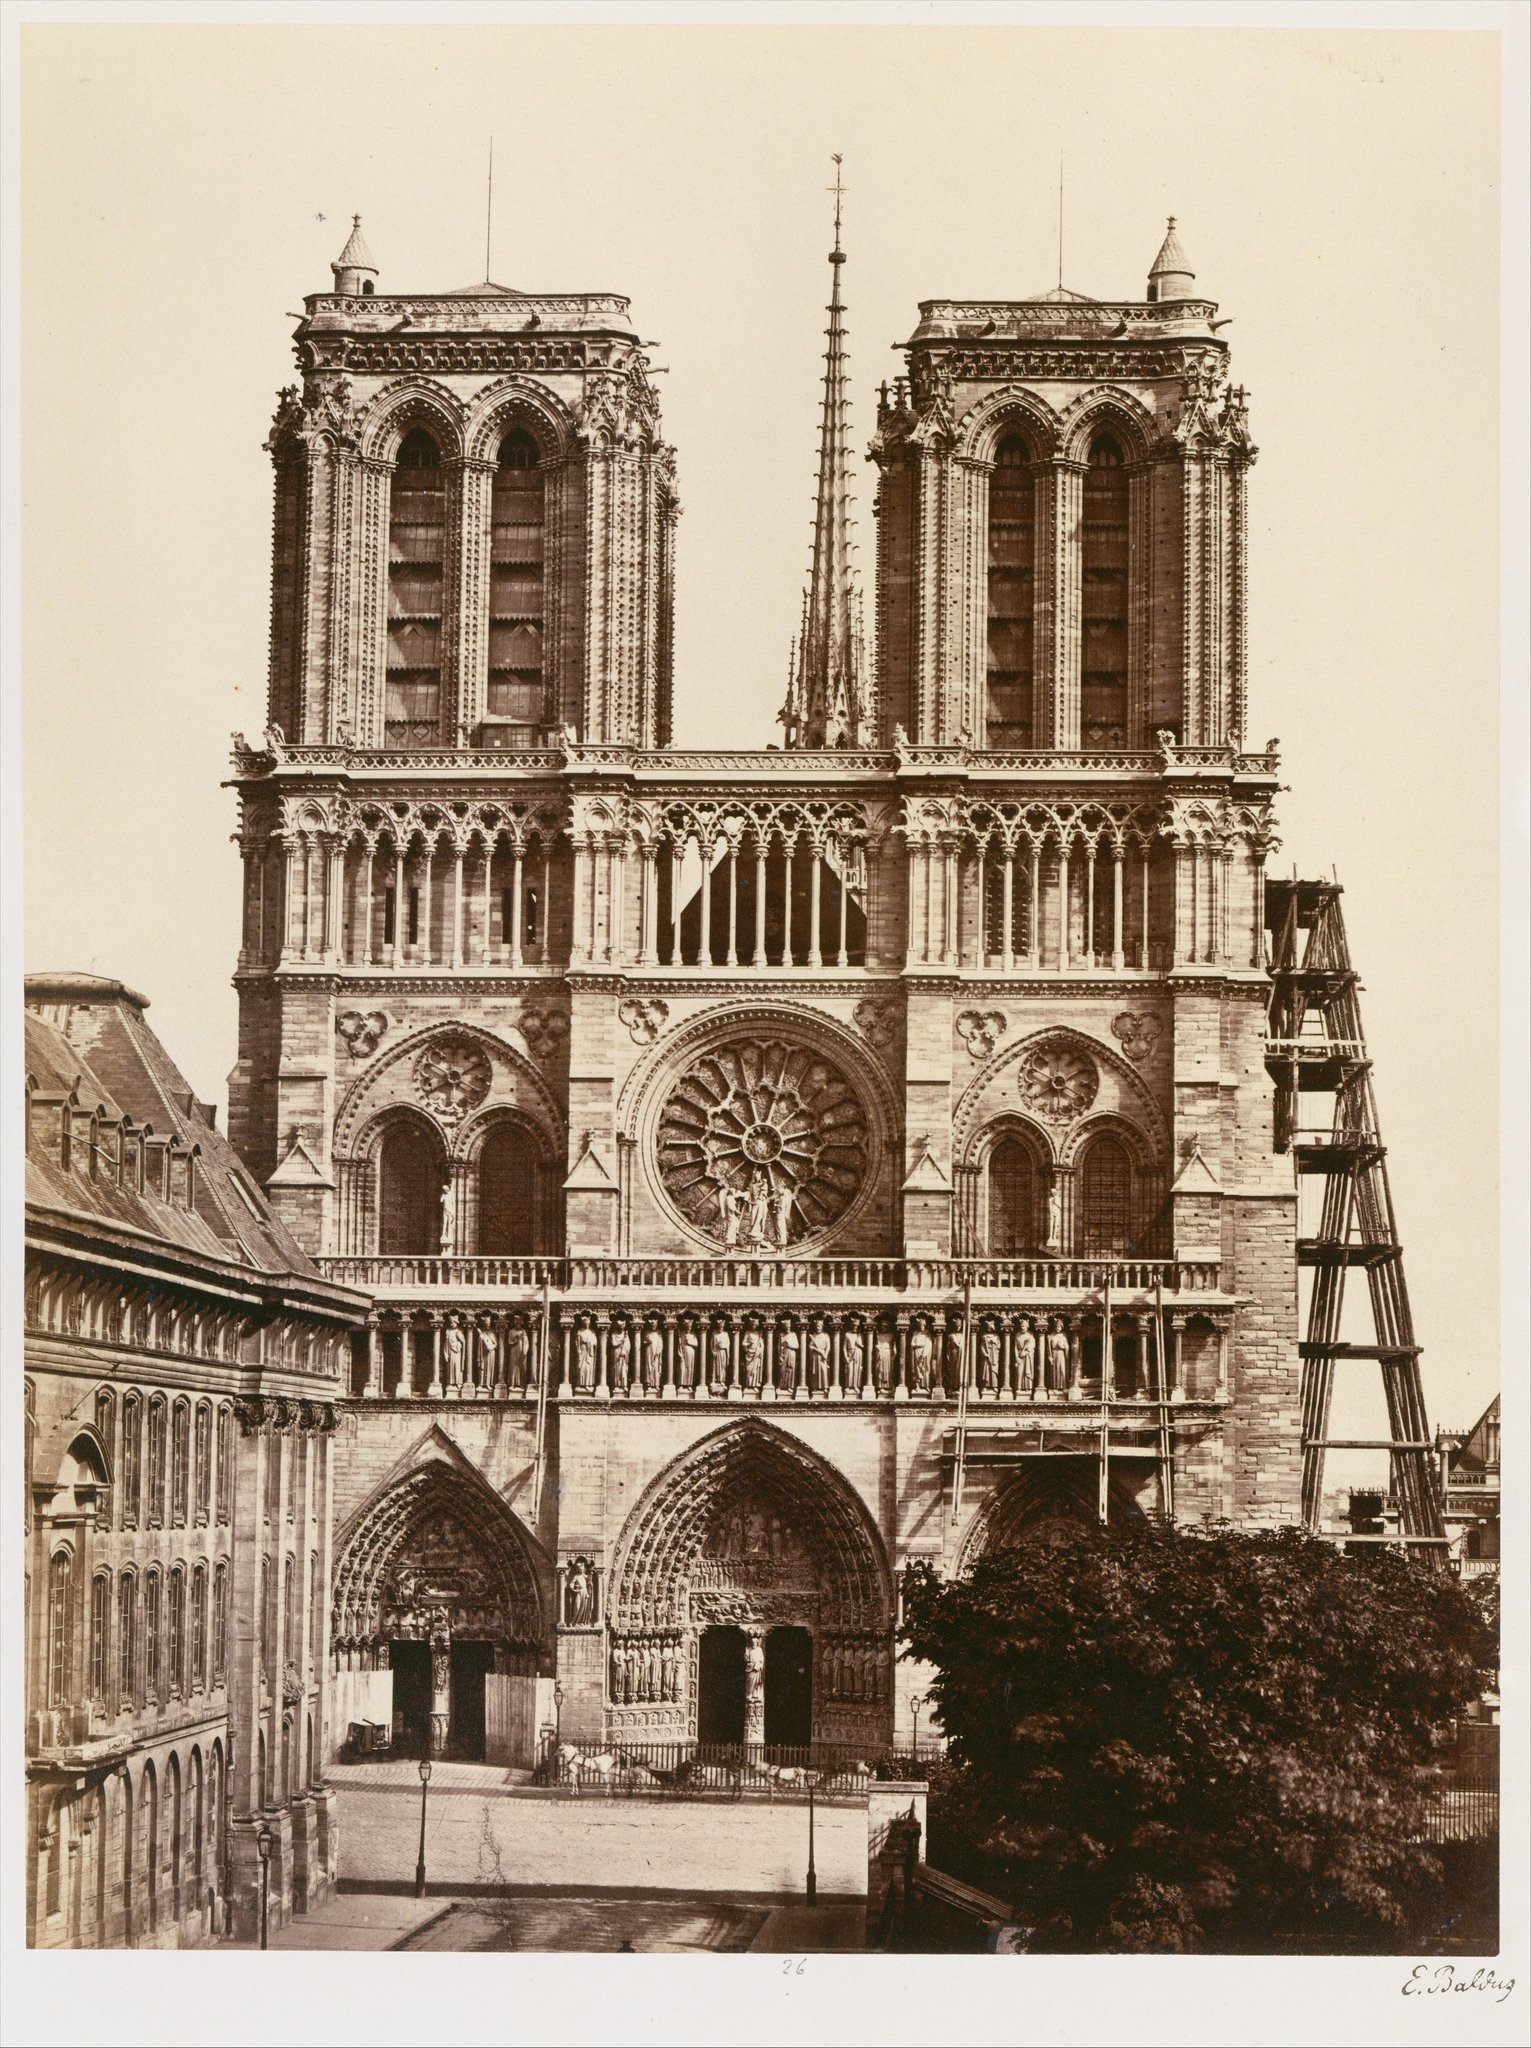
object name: photograph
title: Notre-Dame (façade)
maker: édouard denis baldus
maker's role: fotograaf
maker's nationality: french, born prussia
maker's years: 1813-1889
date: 1860-1869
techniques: albumen silver print, glass negative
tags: architecture,cathedrals